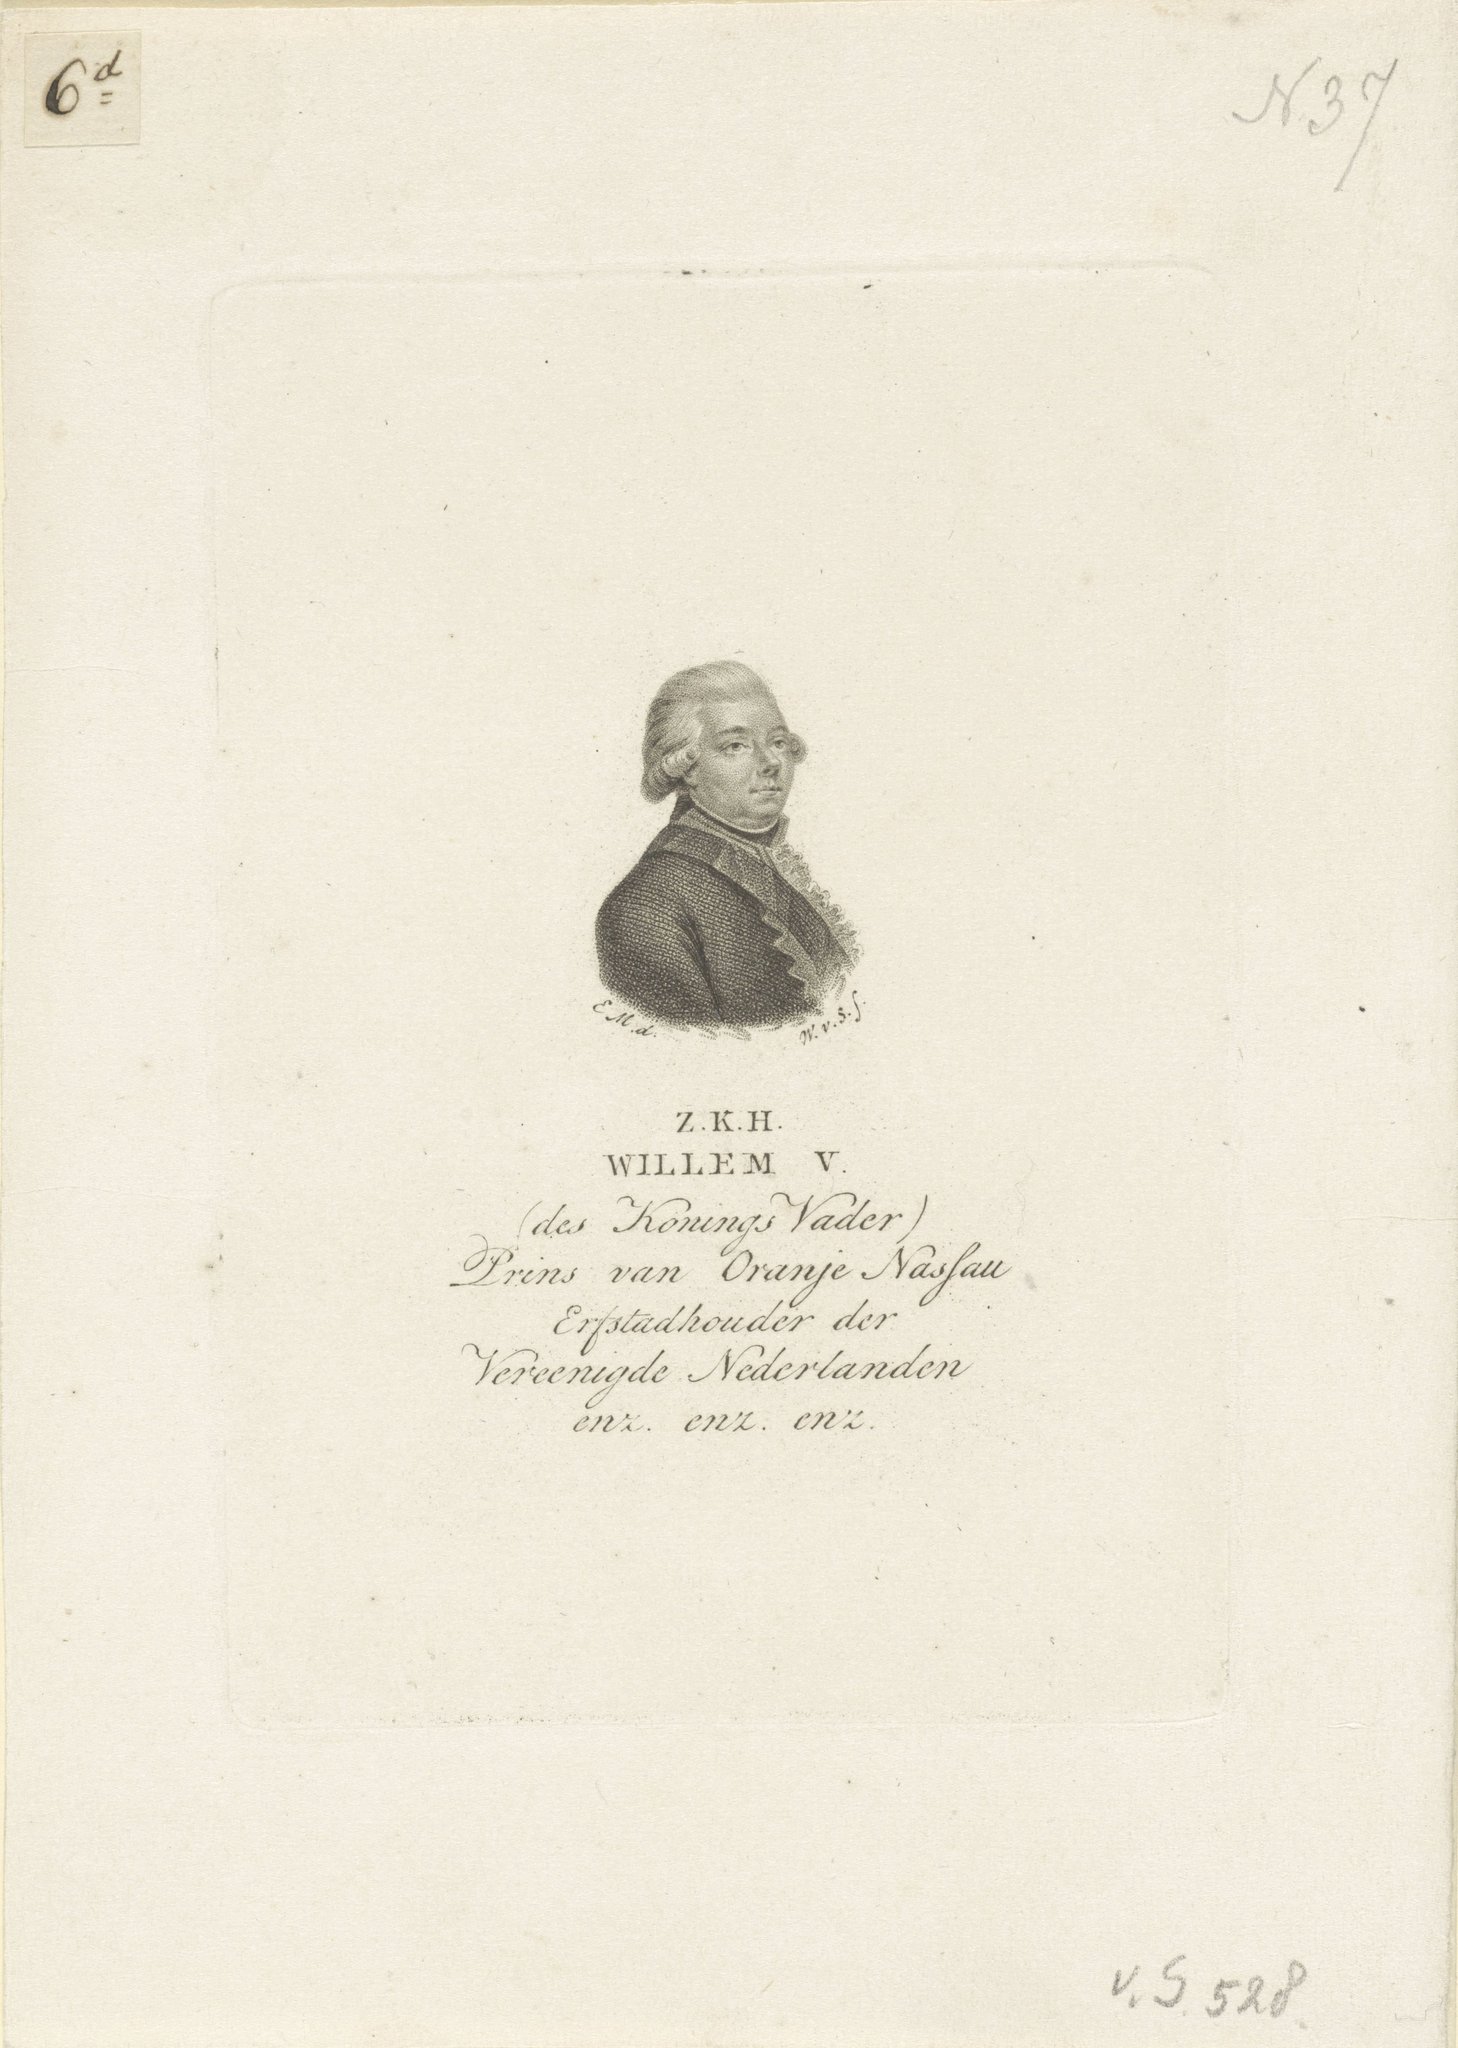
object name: print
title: Portret van Willem V, prins van Oranje-Nassau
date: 1787-1851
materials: paper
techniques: engraving, etching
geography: northern netherlands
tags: the hague, william v (prince of orange)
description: De hier vermelde titel verwijst naar de hoogst verkregen titel van de geportretteerde, niet per se naar de titel die de geportretteerde op deze voorstelling draagt.